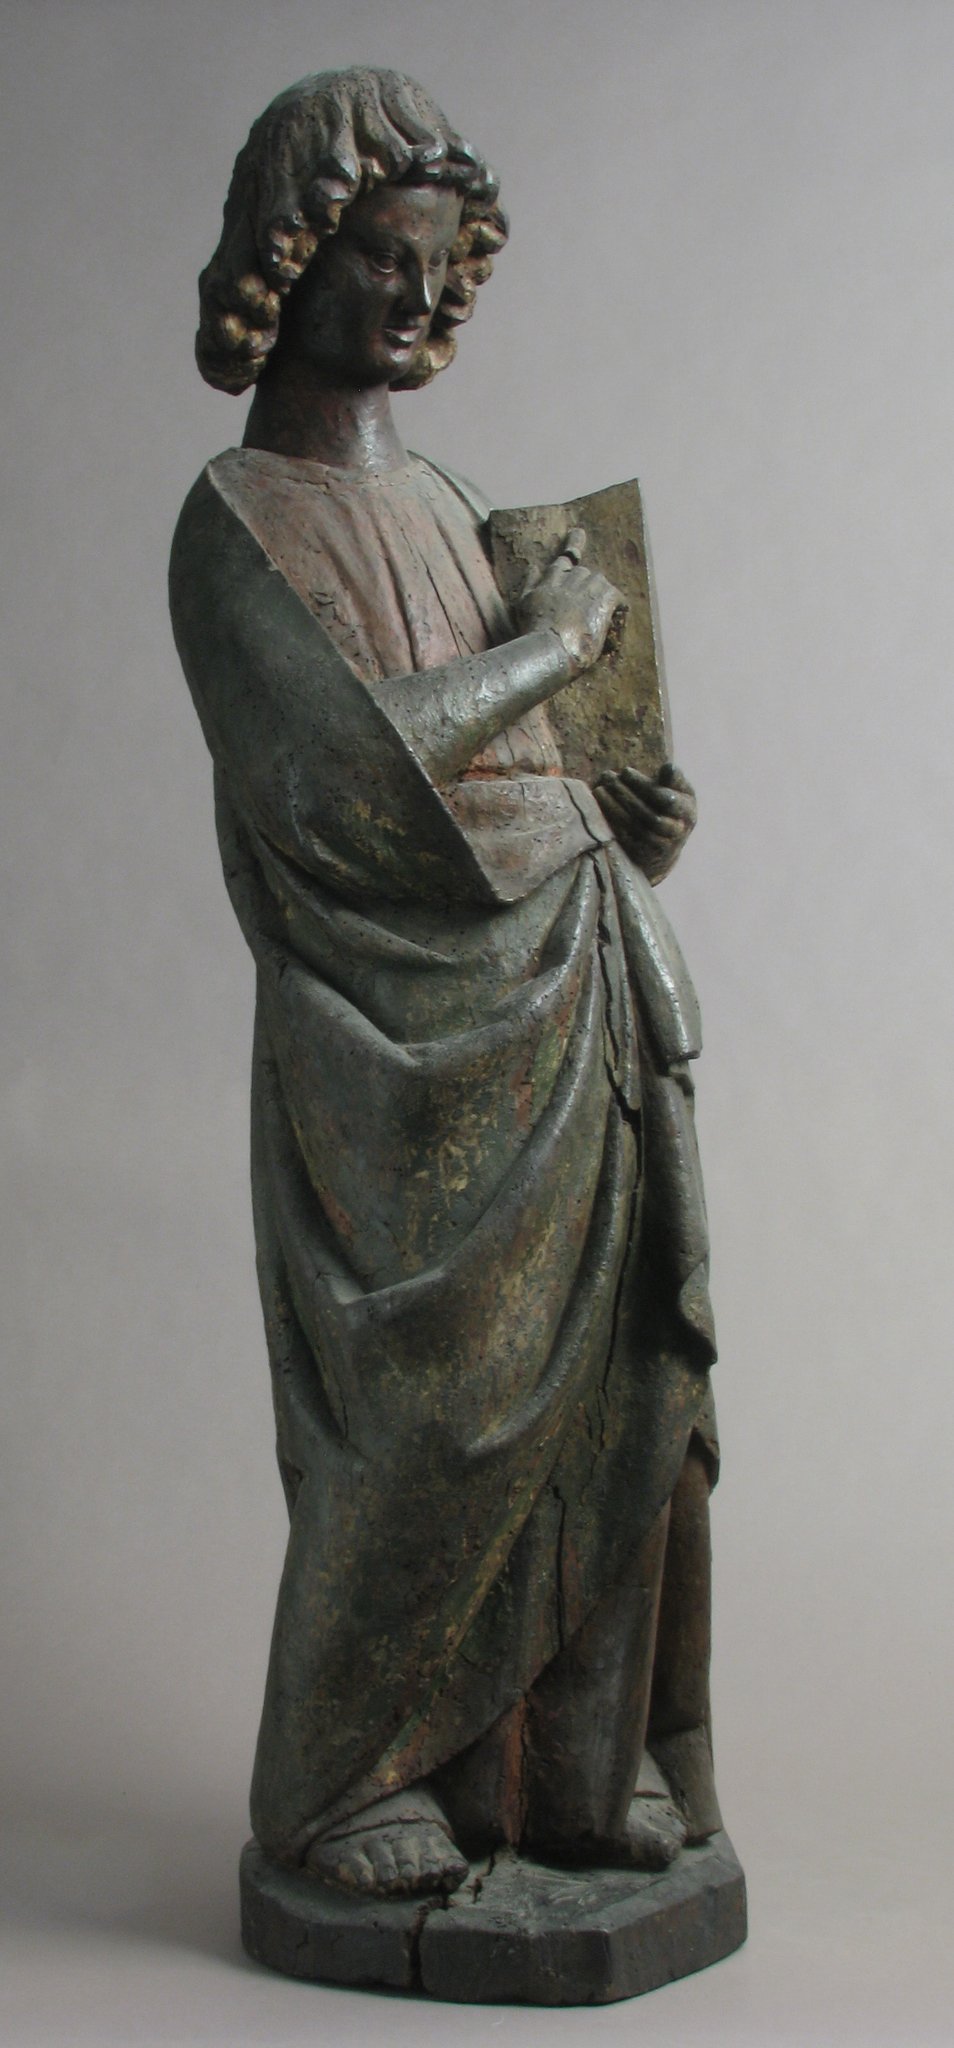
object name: statue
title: Saint John The Evangelist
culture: french or spanish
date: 1301-1400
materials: wood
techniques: polychromy